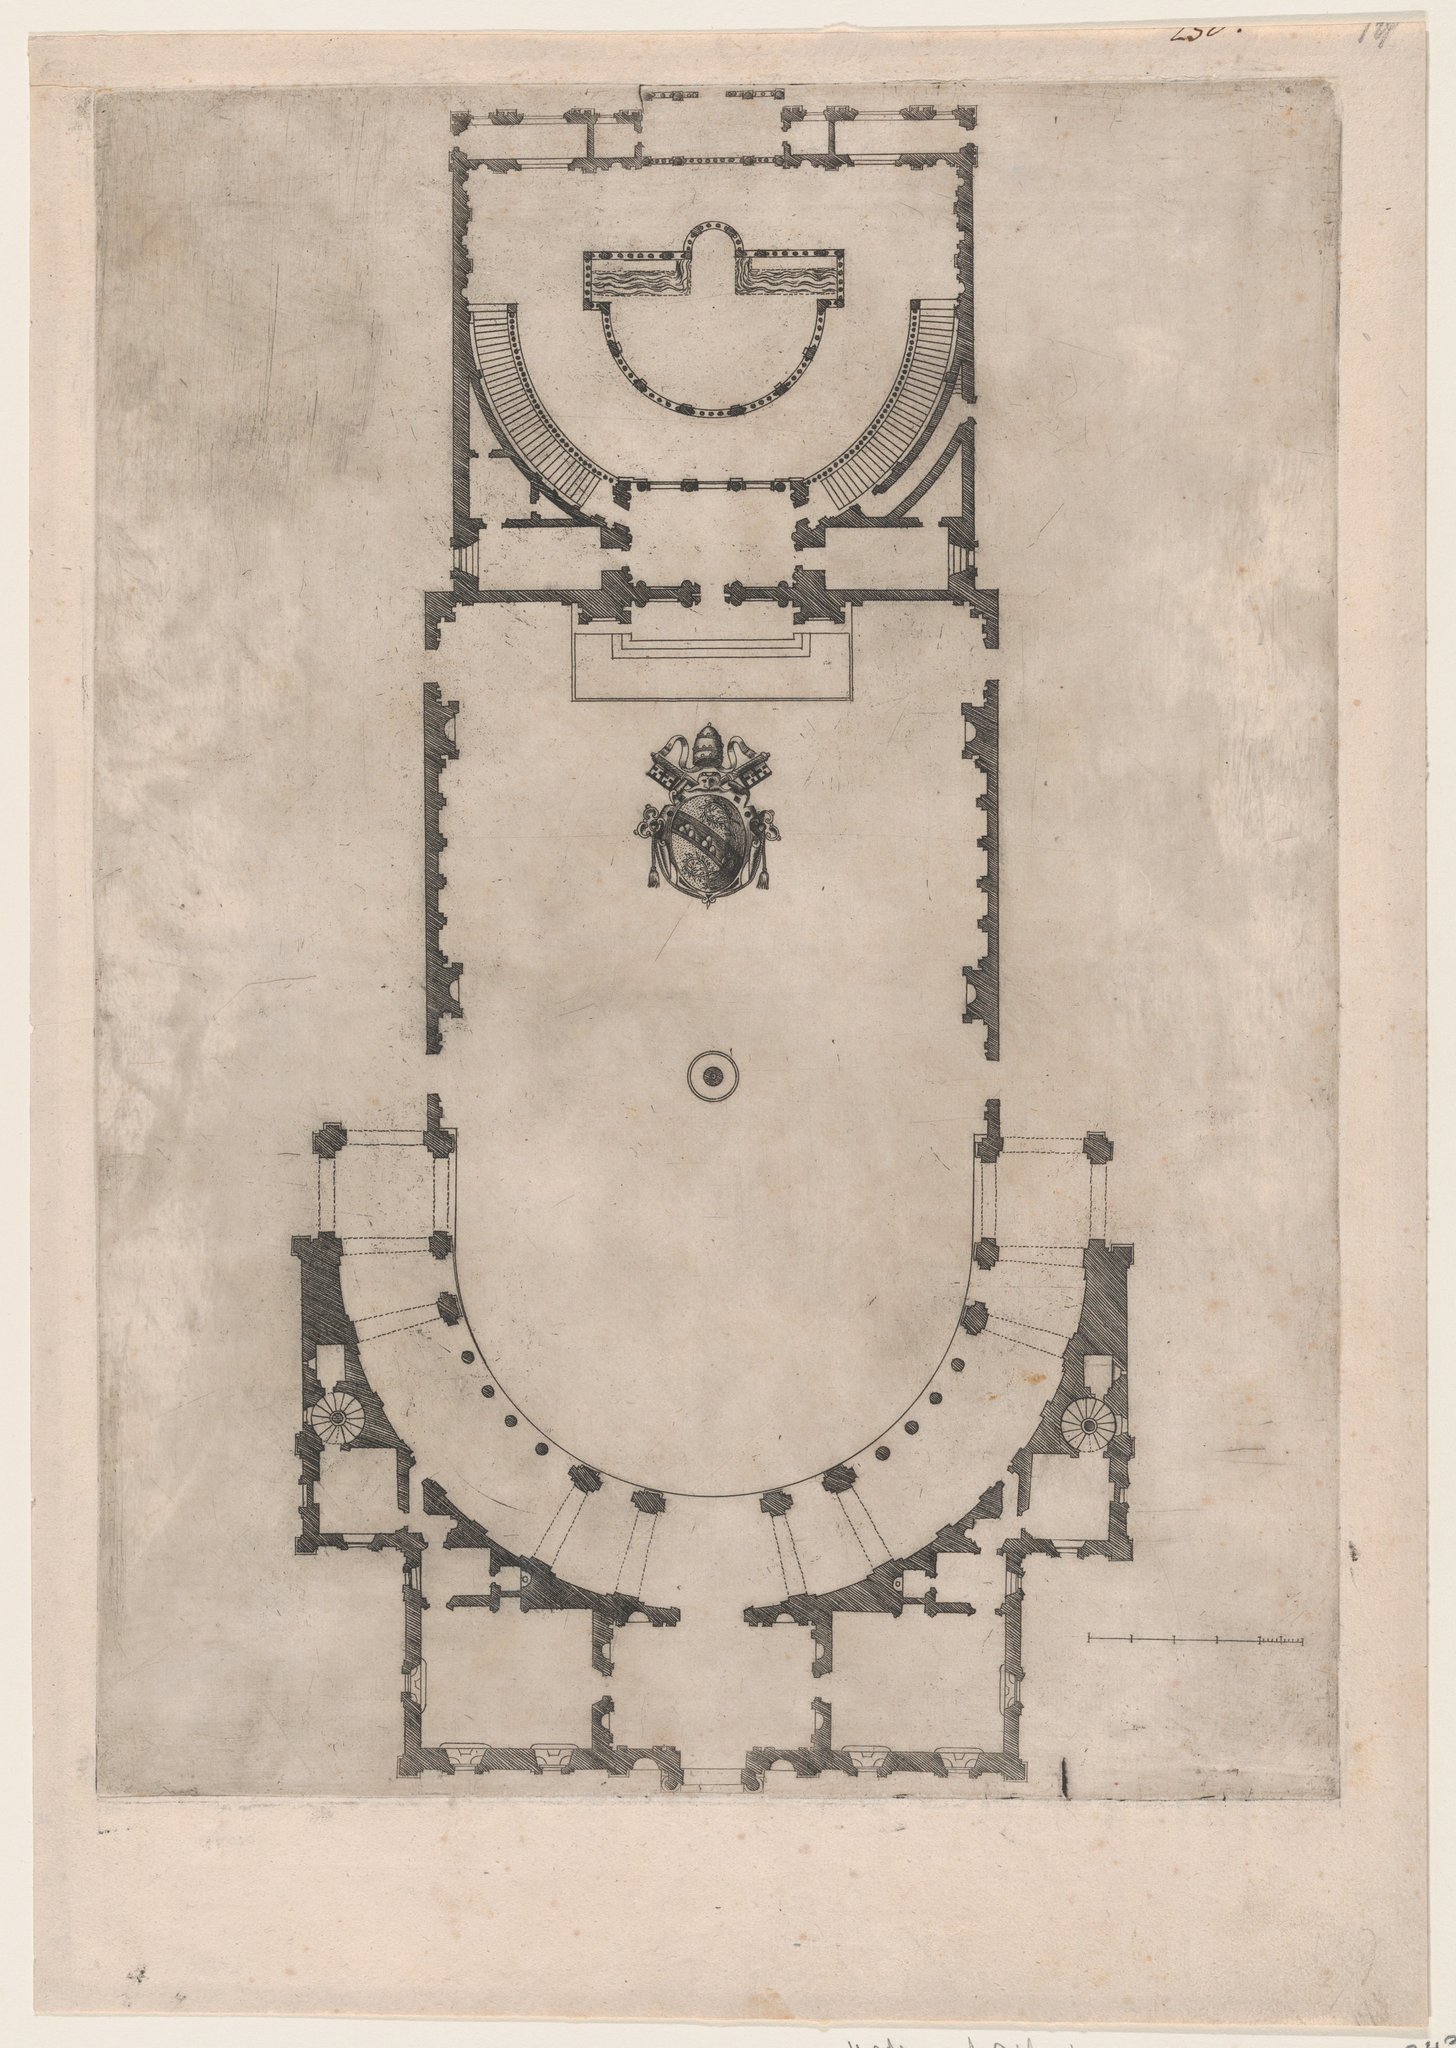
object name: print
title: Floor plan of the Villa Giulia in Rome with the arms of Pope Julius III engraved at the center, from "Speculum Romanae Magnificentiae"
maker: Anonymous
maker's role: artist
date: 1501-1600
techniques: engraving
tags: architecture,rome